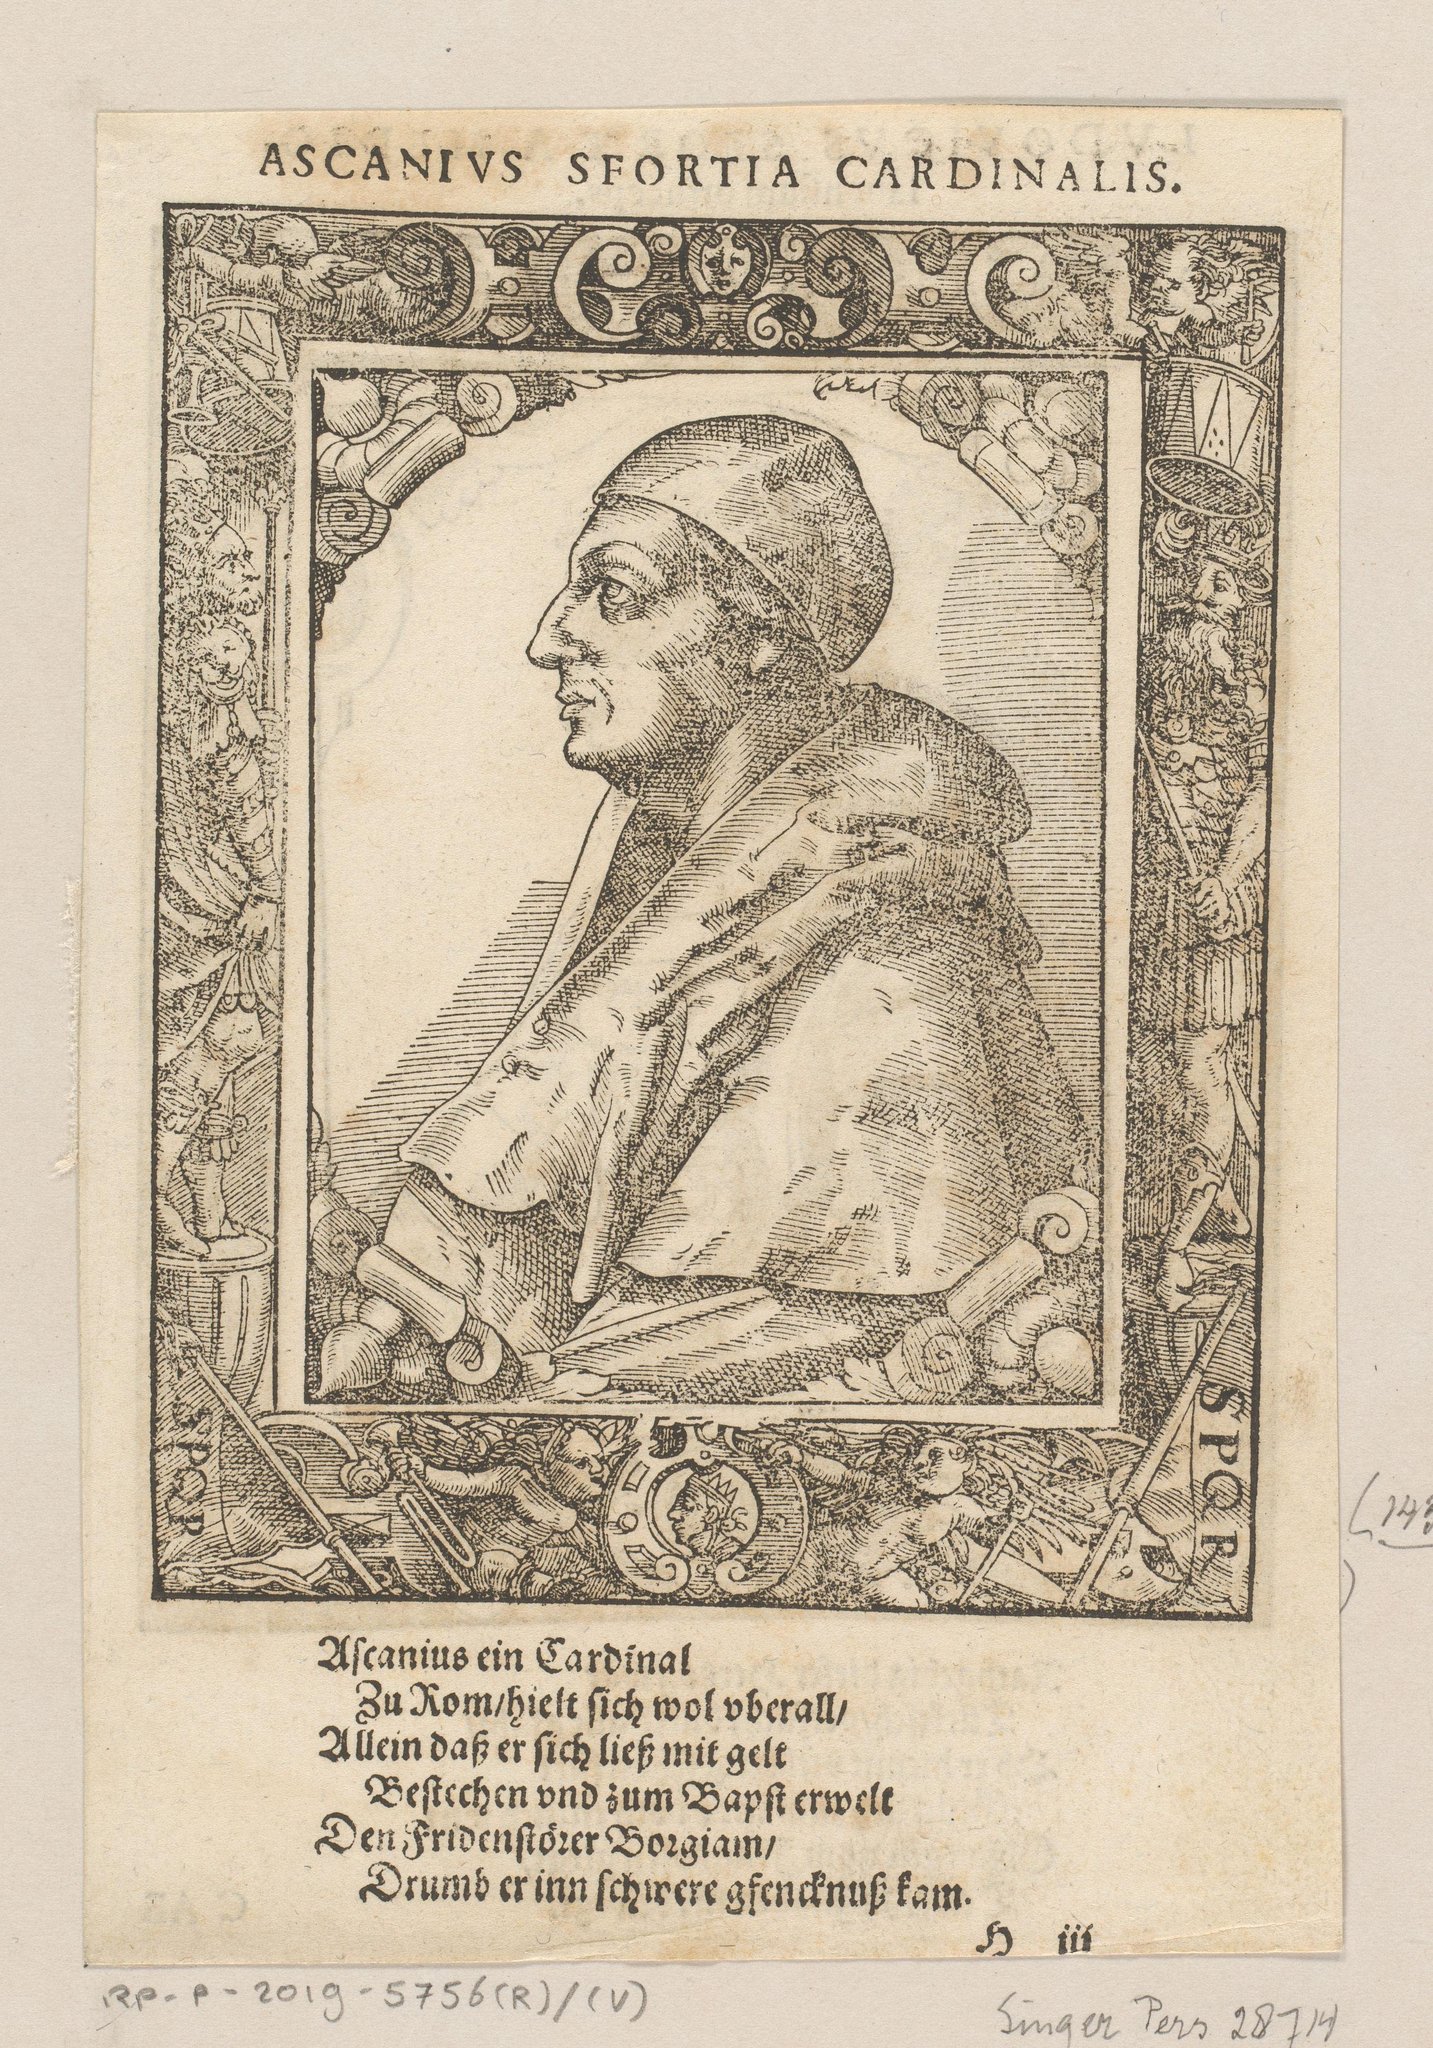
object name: book illustration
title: Portret van Ascanio Maria Sforza Visconti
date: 1577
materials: paper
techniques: letterpress printing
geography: basel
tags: cardinal, historical persons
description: Prent uit: Müller, Theobald. Eigentliche und gedenkwürdige Contrafacturen oder Anbildungen wolverdienter unnd Weitberümter Kriegshelden, (...). Bazel: Peter Perna, 1577. Prent eerder verschenen in: Giovio, Paolo. Elogia virorum bellica virtute illustrium (...). Bazel: Peter Perna, 1575. Prent ook gebruikt in latere publicaties.